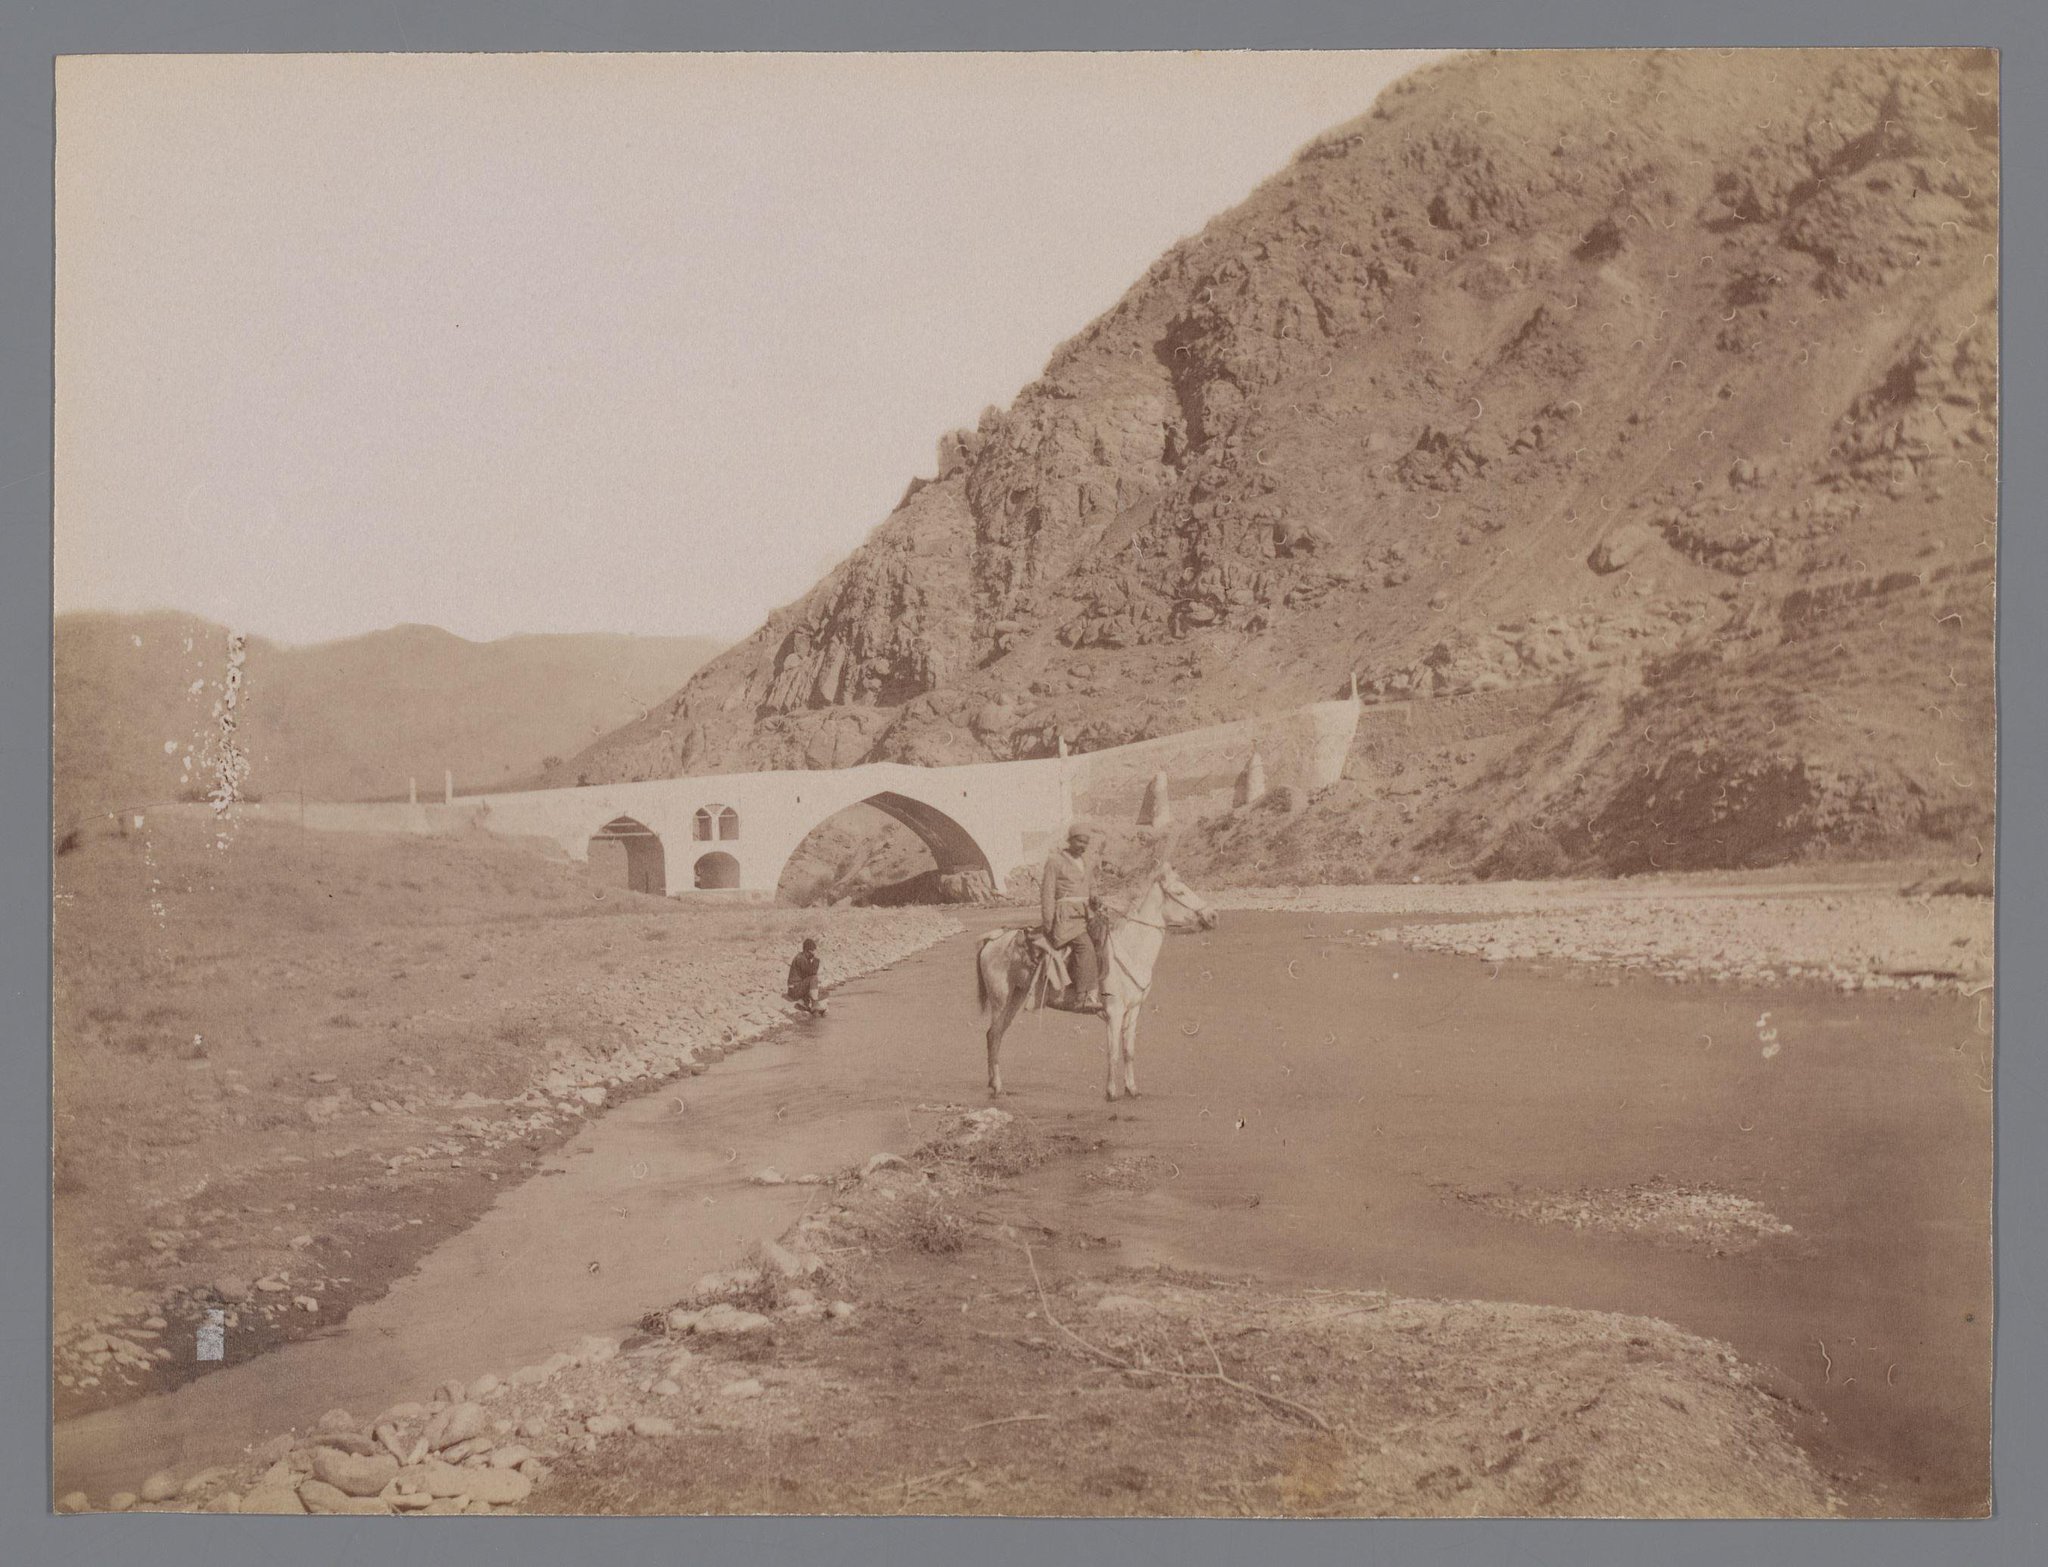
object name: photograph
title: Landschap met een brug en een rivier met daarin een ruiter te paard en heuvels aan weerszijden ("La route de Rescht, Pont Kerezje [?]"), Iran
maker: antoine sevruguin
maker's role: fotograaf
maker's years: 1840-1933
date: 1880-1910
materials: paper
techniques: albumen print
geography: iran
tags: iran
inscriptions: number: ‘6’, number: ‘26.’, inscription: ‘La route de Rescht//Pont Keredje’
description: Landschap met een brug en een rivier met daarin een ruiter te paard en heuvels aan weerszijden ("La route de Rescht, Pont Kerezje [?]"), Iran.